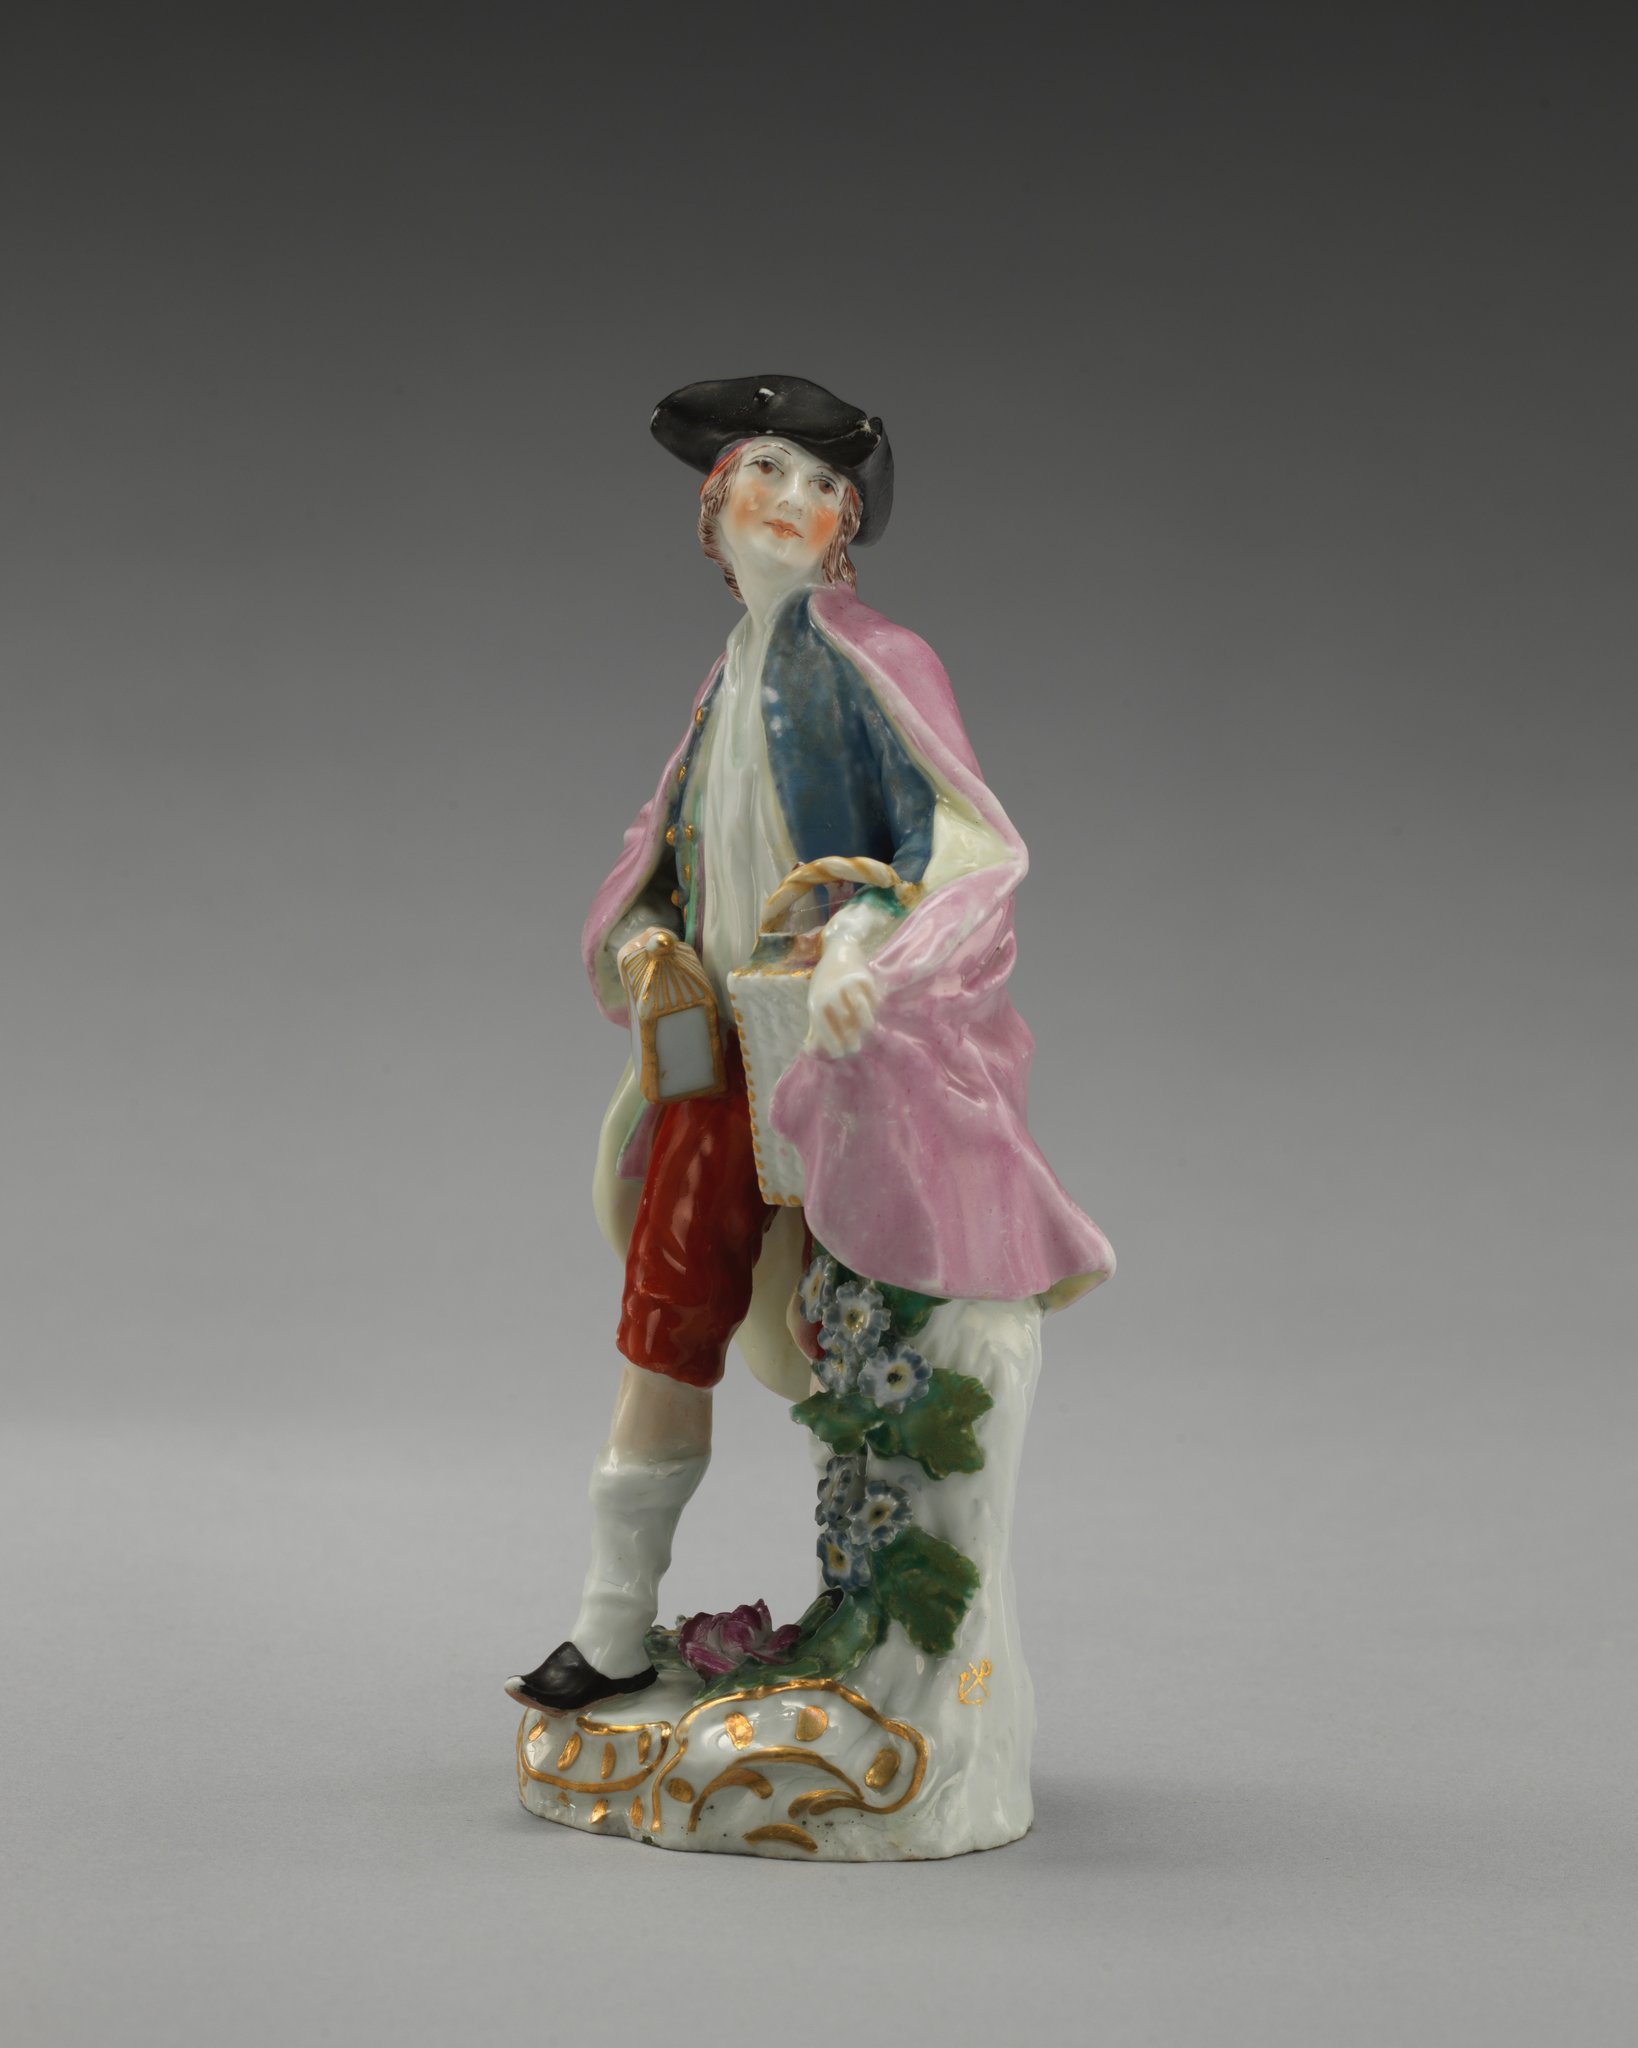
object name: figure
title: Nightwatchman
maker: chelsea porcelain manufactory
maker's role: factory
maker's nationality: british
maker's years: 1744-1784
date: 1760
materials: soft paste porcelain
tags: men,women,flowers